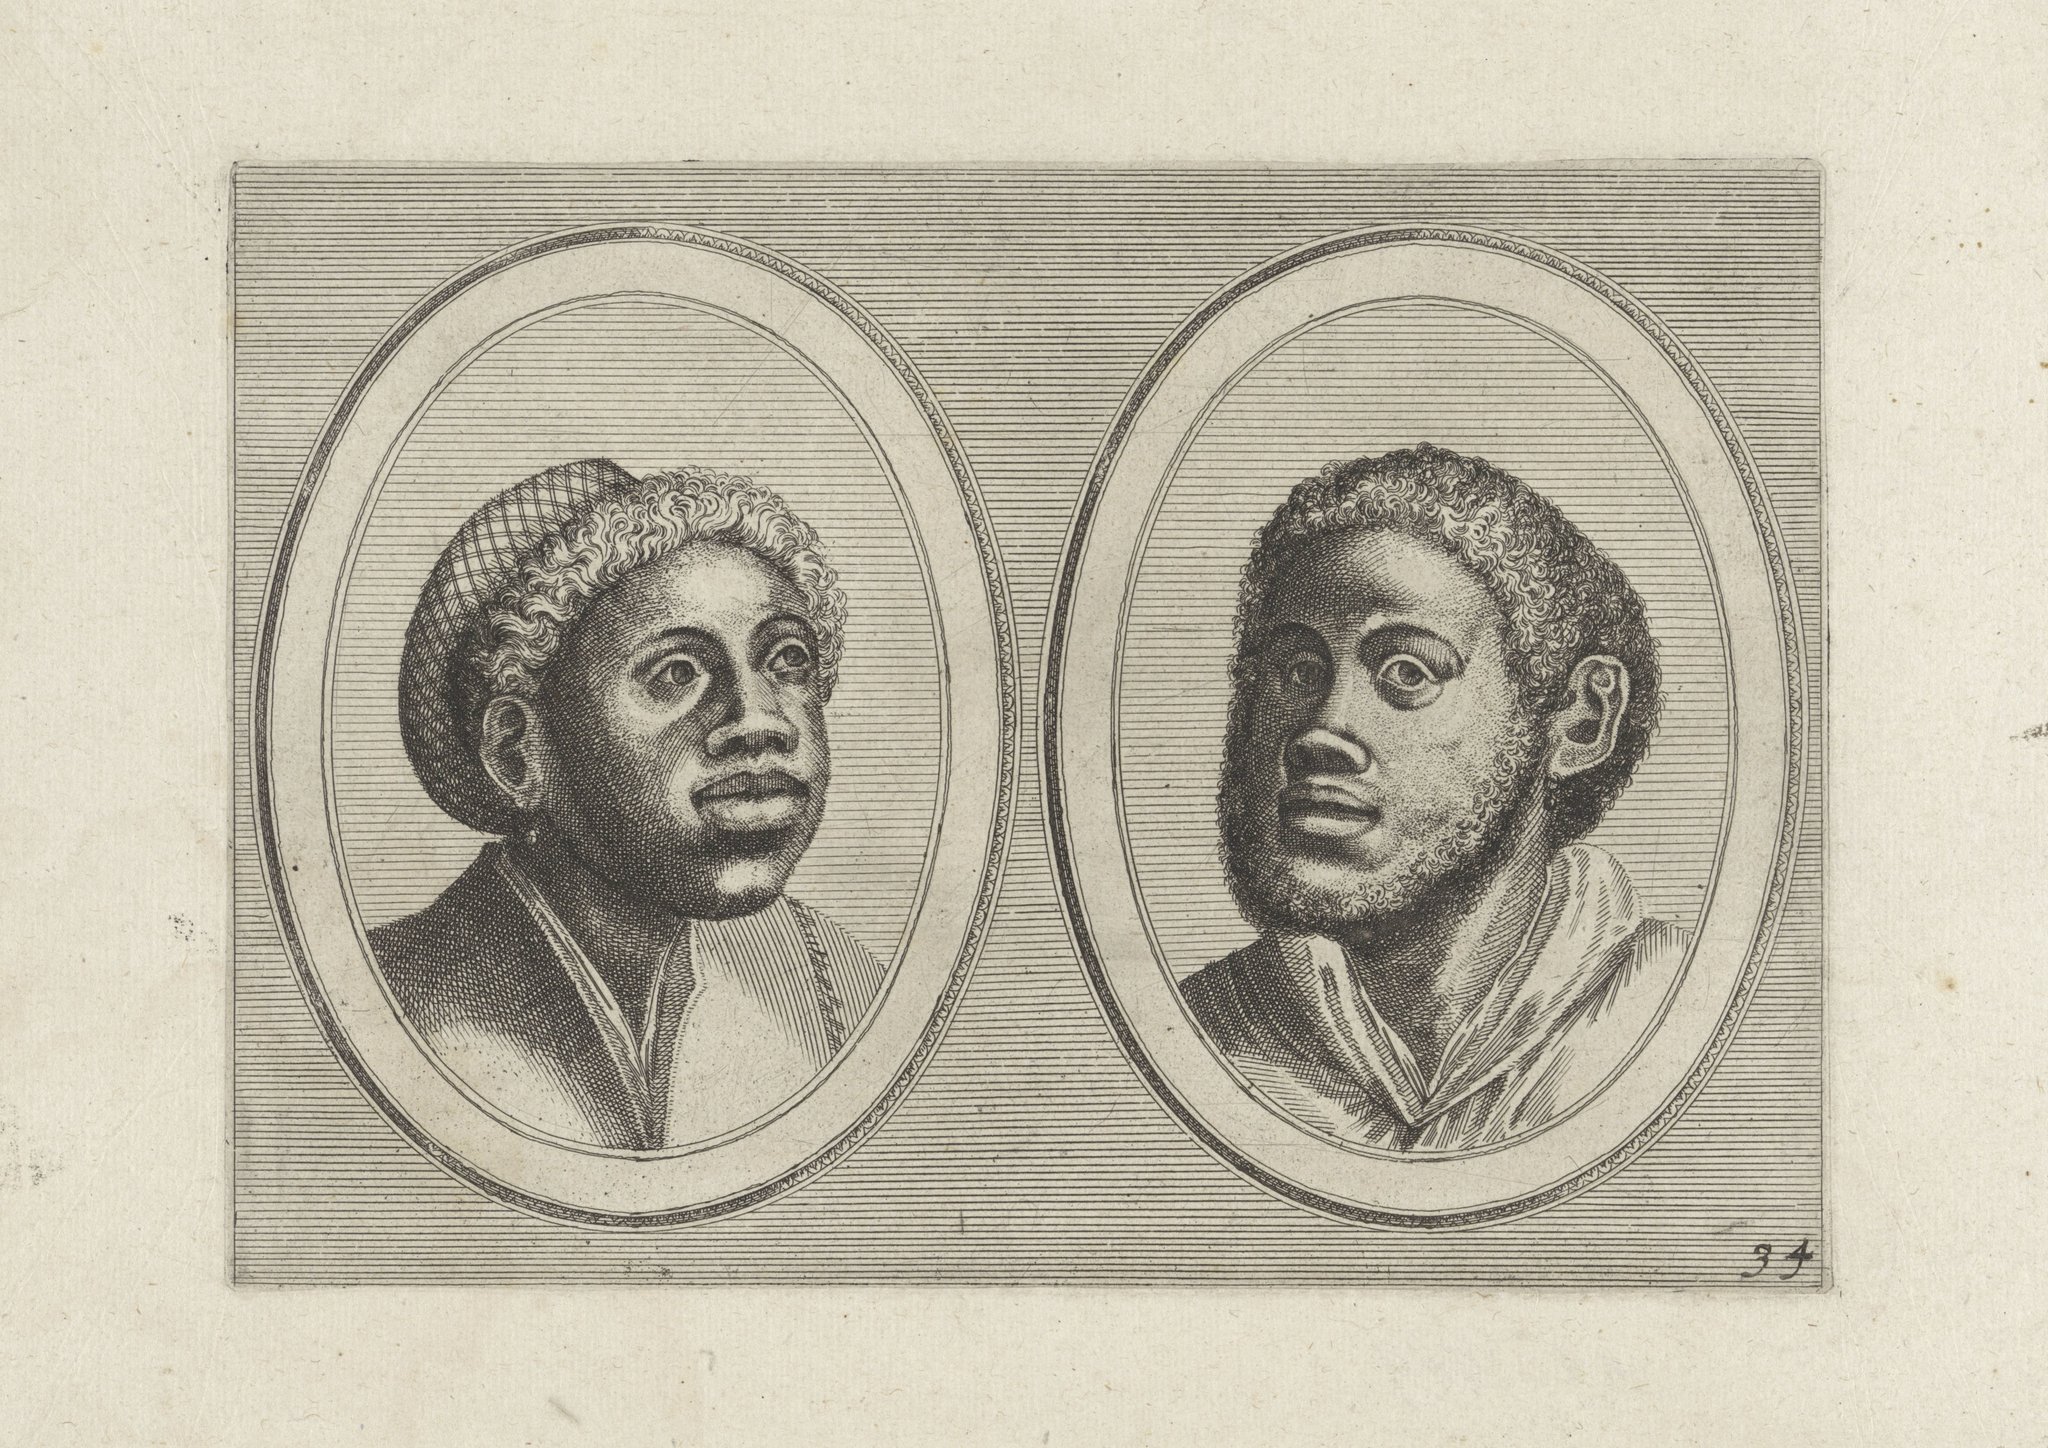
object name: print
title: Boerenkoppen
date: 1612-1652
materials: paper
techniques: engraving, etching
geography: amsterdam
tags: head-gear, farmers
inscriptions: collector's mark: Lugt 240, collector's mark: Lugt 700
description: Prent uit een serie van 36 prenten met koppen van boeren en boerinnen.